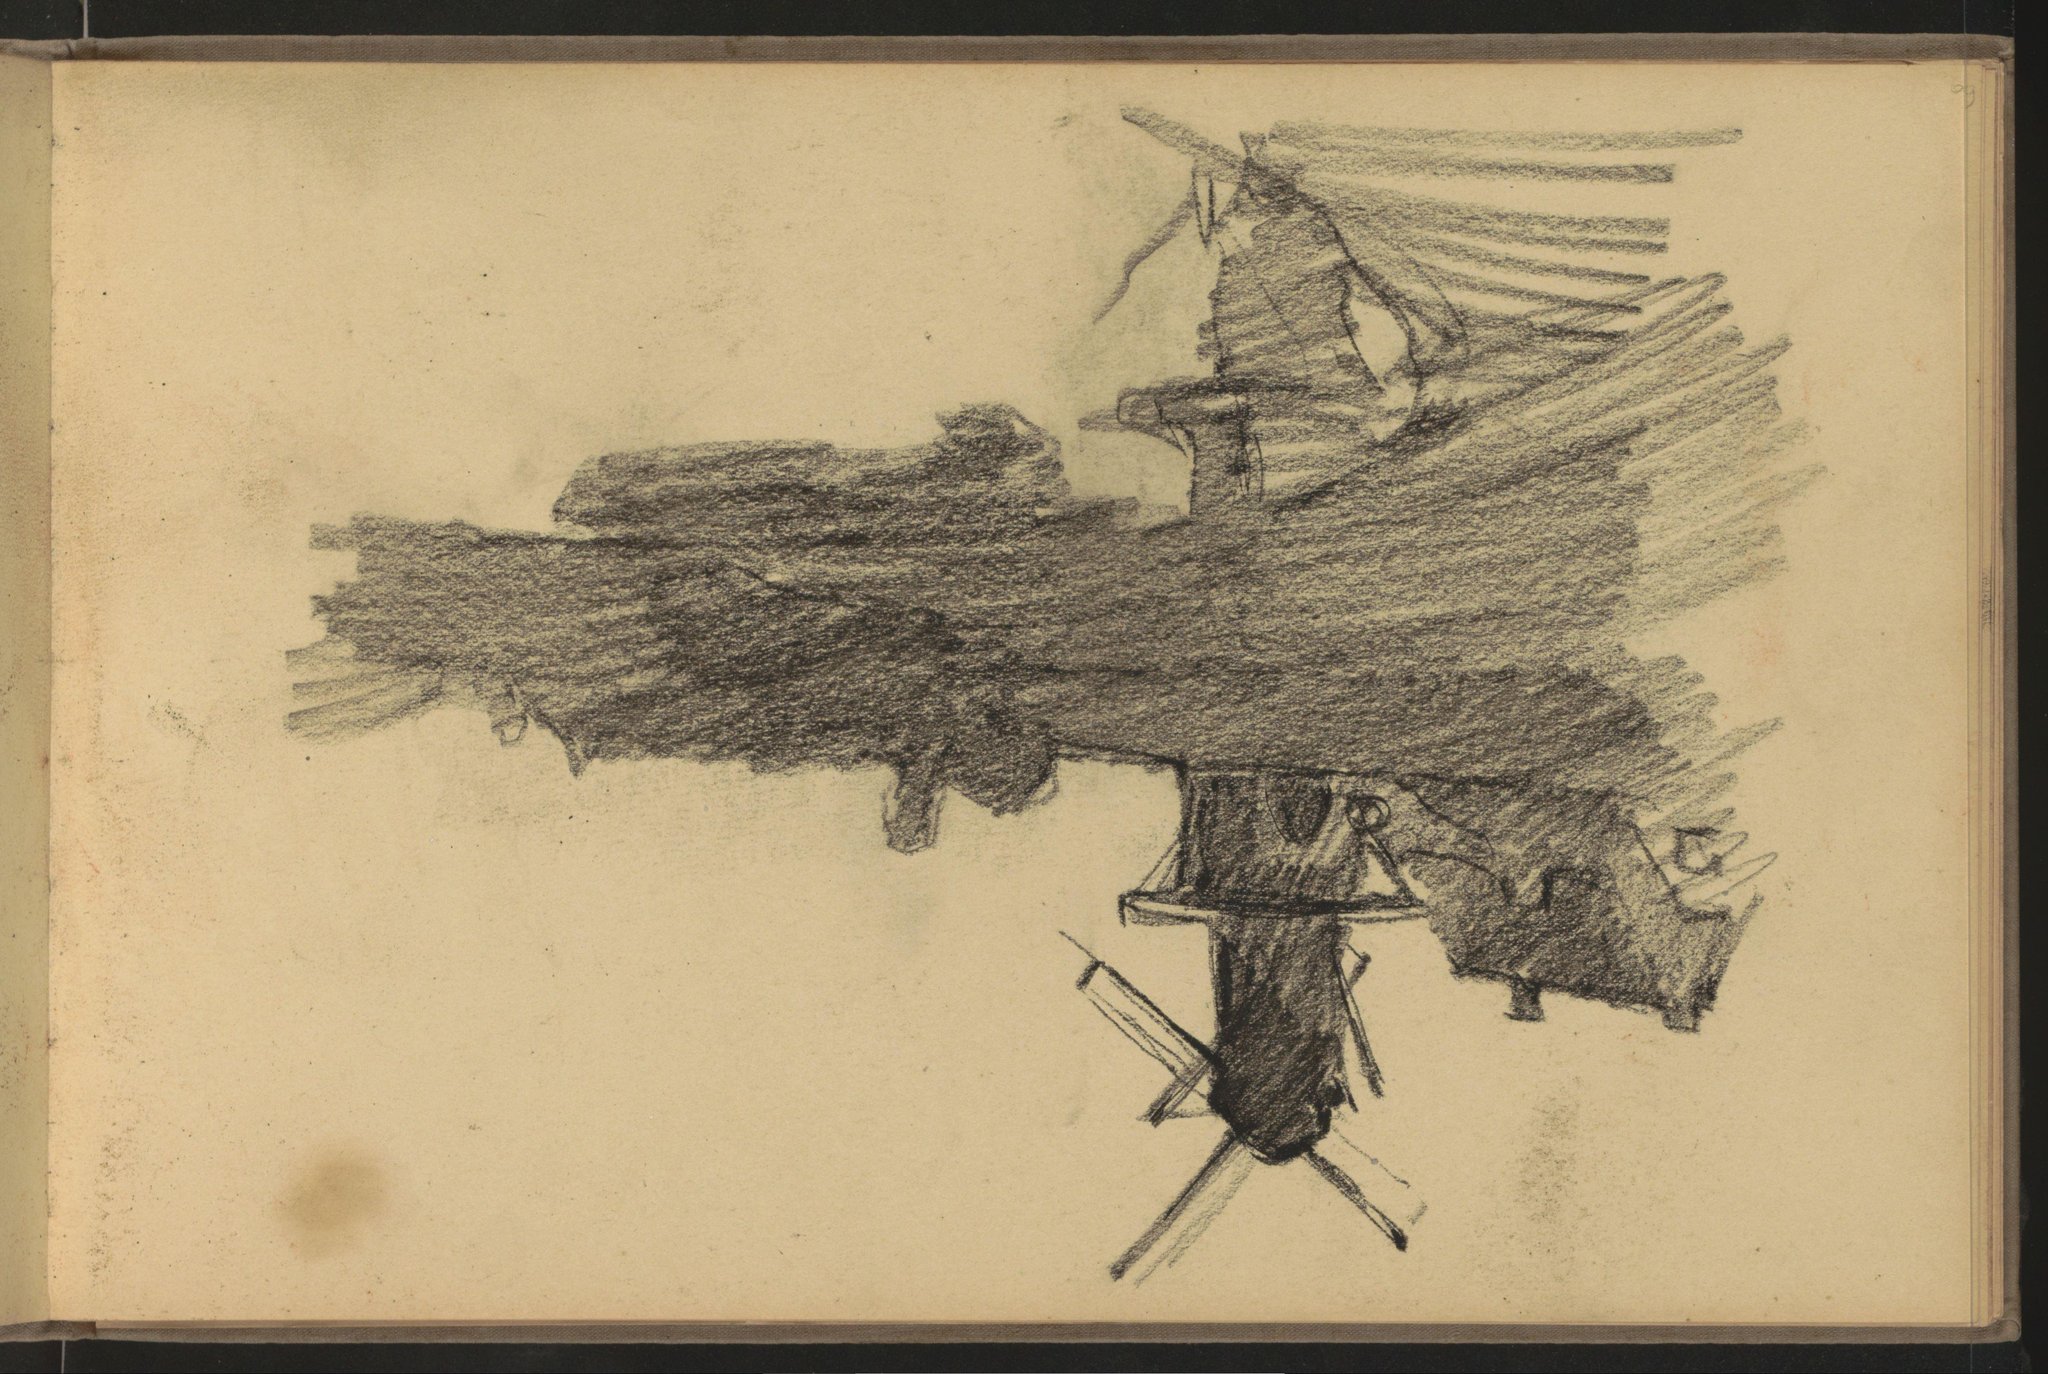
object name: sketchbook leaf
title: Gezicht op de molen Rijn en Lek te Wijk bij Duurstede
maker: willem witsen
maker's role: draughtsman, painter, print maker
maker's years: 1860-1923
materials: chalk, paper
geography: wijk bij duurstede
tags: river, windmill, lower rhine region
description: Voorstudie voor de ets 'Molen aan het water, Wijk bij Duurstede, de rivier links', ca. 1906.